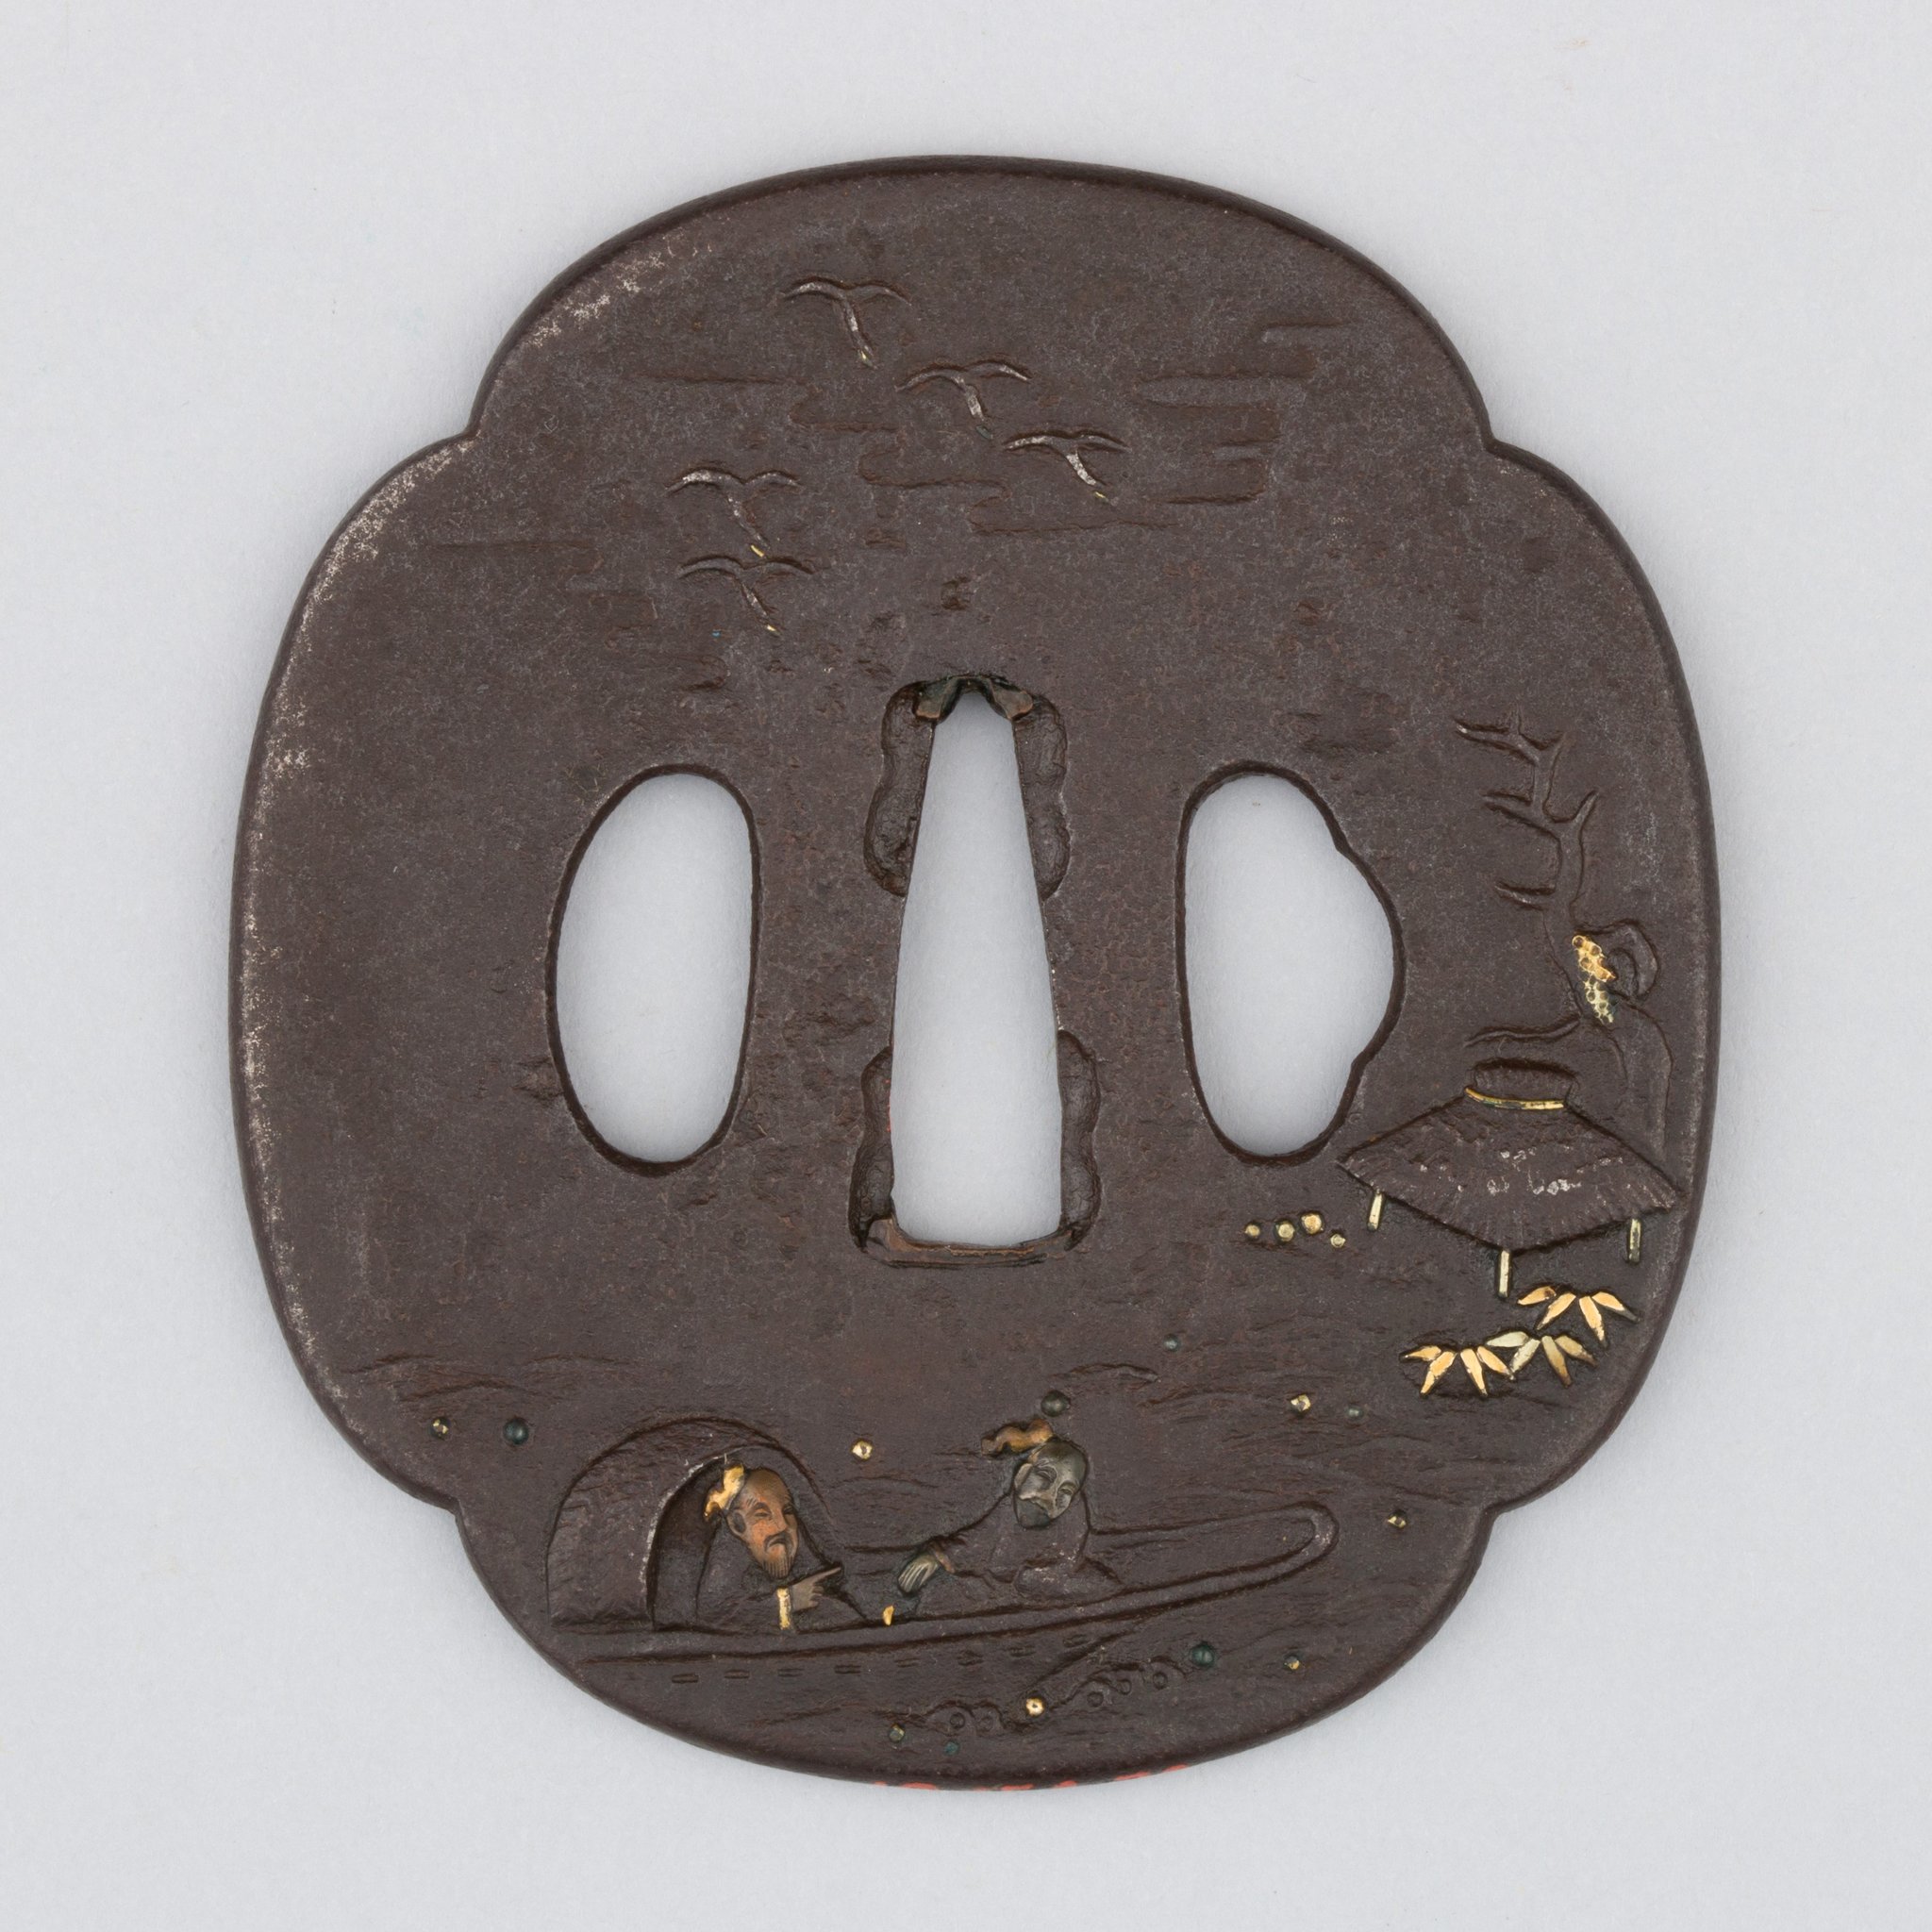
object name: sword guard tsuba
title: Sword Guard (Tsuba)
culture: japanese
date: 1601-1700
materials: copper, silver alloy, gold, iron, silver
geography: japan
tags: birds,men,boats